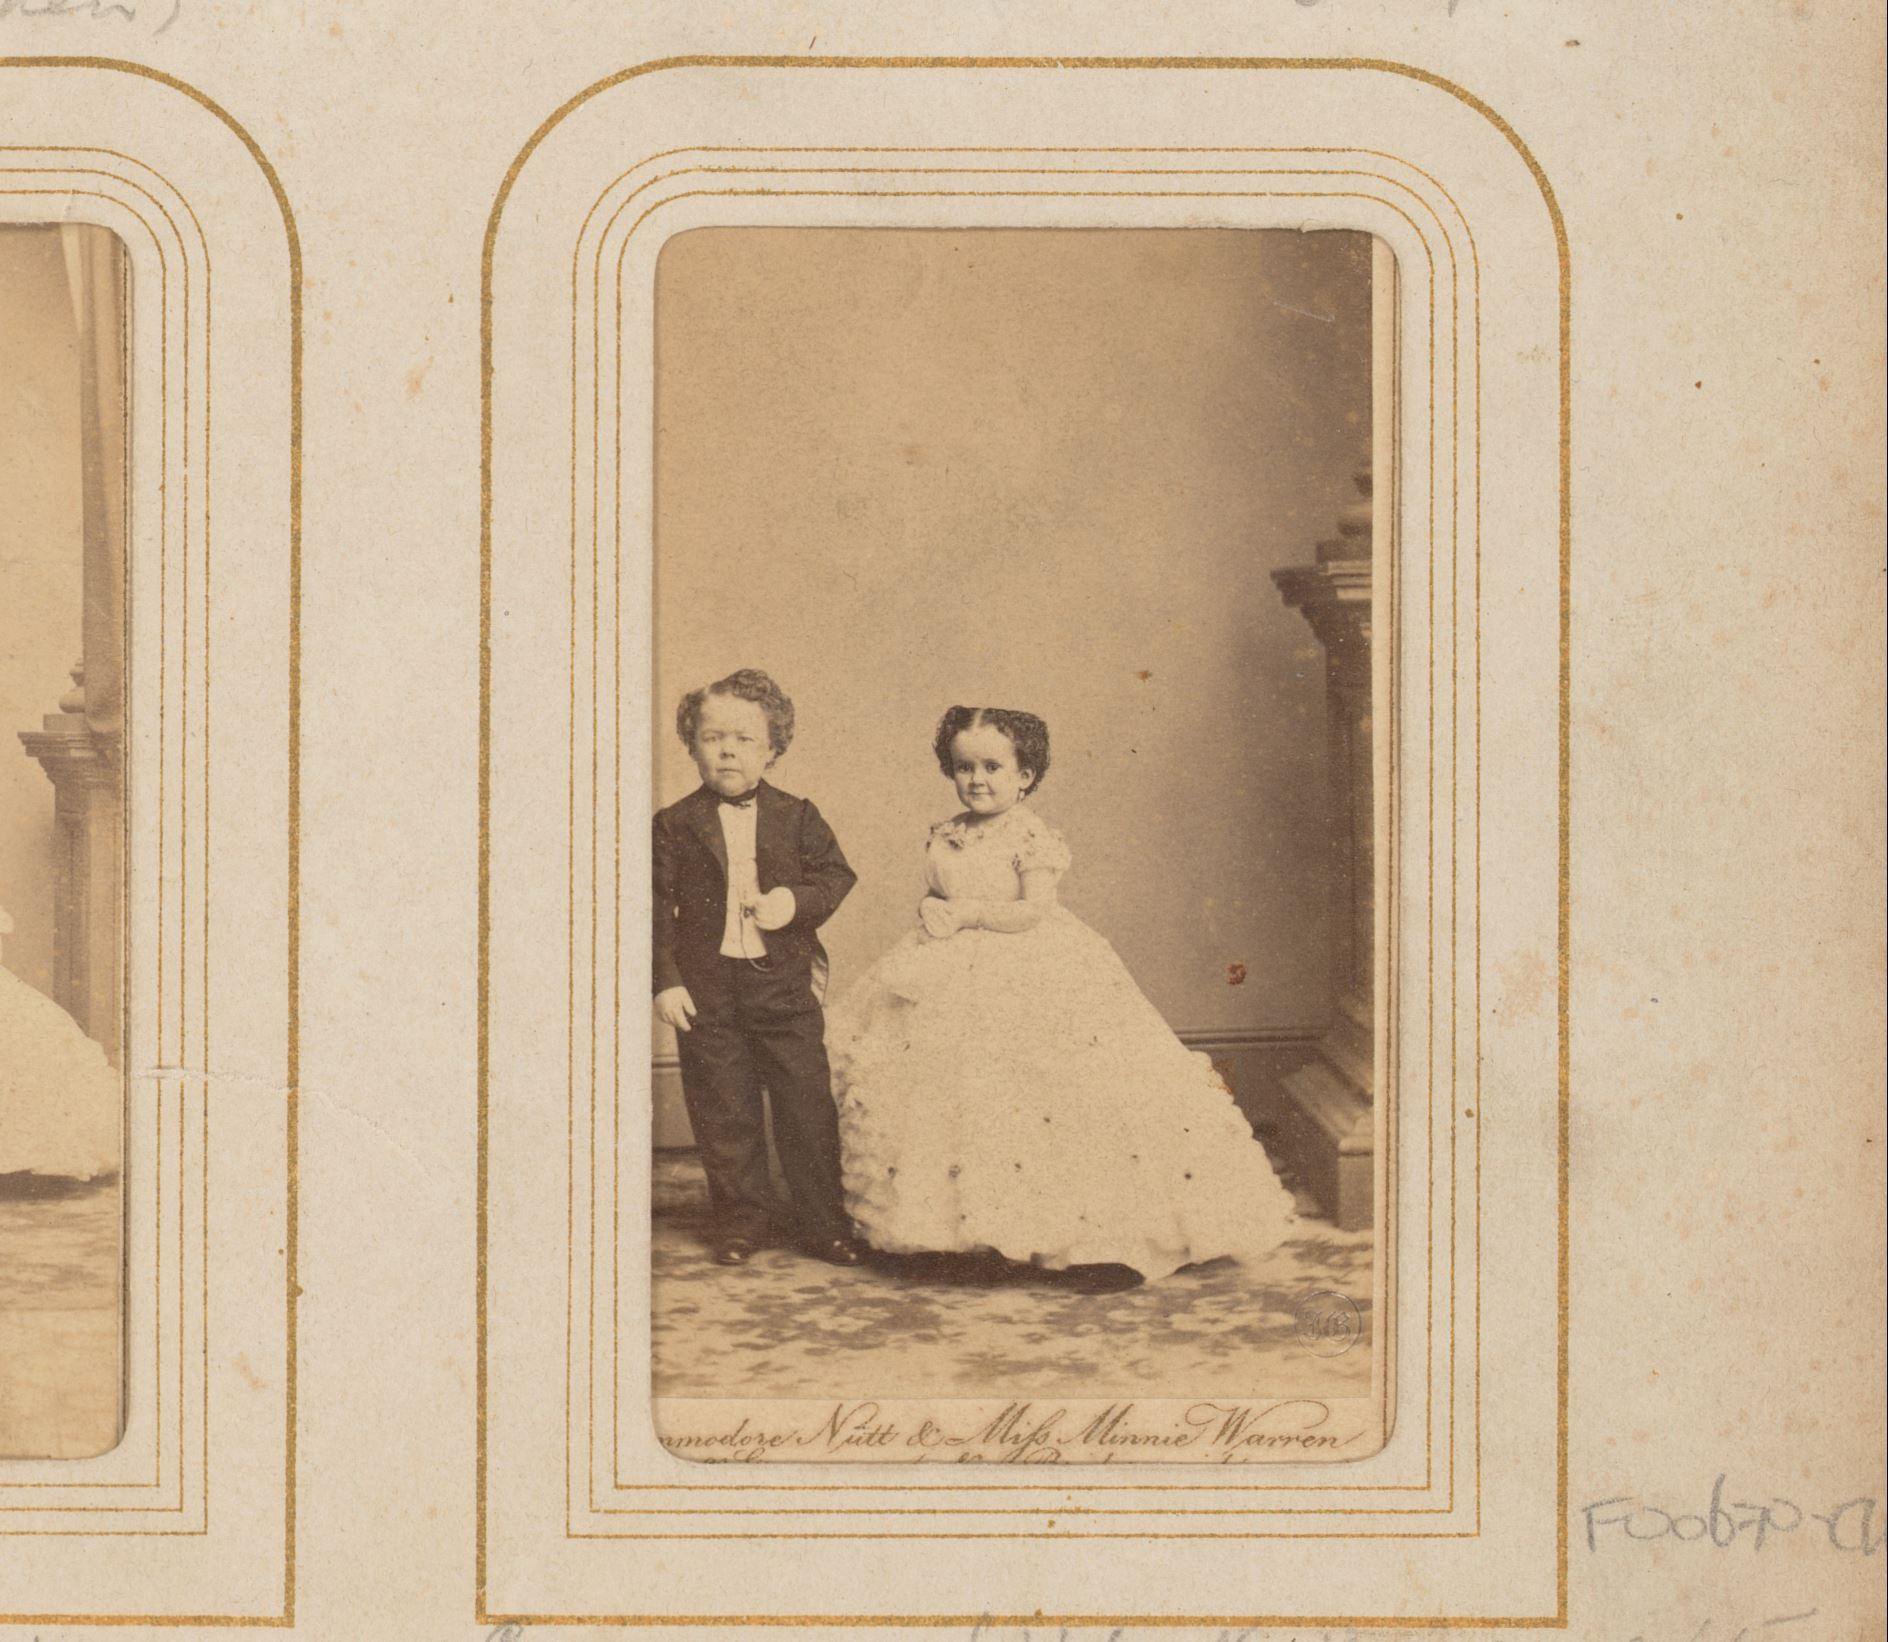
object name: album leaf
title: Portret van Commodore Nutt en Minnie Warren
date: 1864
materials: cardboard, photographic support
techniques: albumen print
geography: new york city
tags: new york (city), historical persons - bb - woman, historical persons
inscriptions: annotation: ‘G.W.M. Nutt/ Minnie Warren’, inscription: ‘Published by/ E & H.T. Anthony/ 50 Broadway/ New York/ From photographic negative in Brady's National Portrait Gallery’, annotation: ‘Commodore G.W.M. Nutt en Mercy Lavinia Warren/ (met opdracht)/ (Brady)’